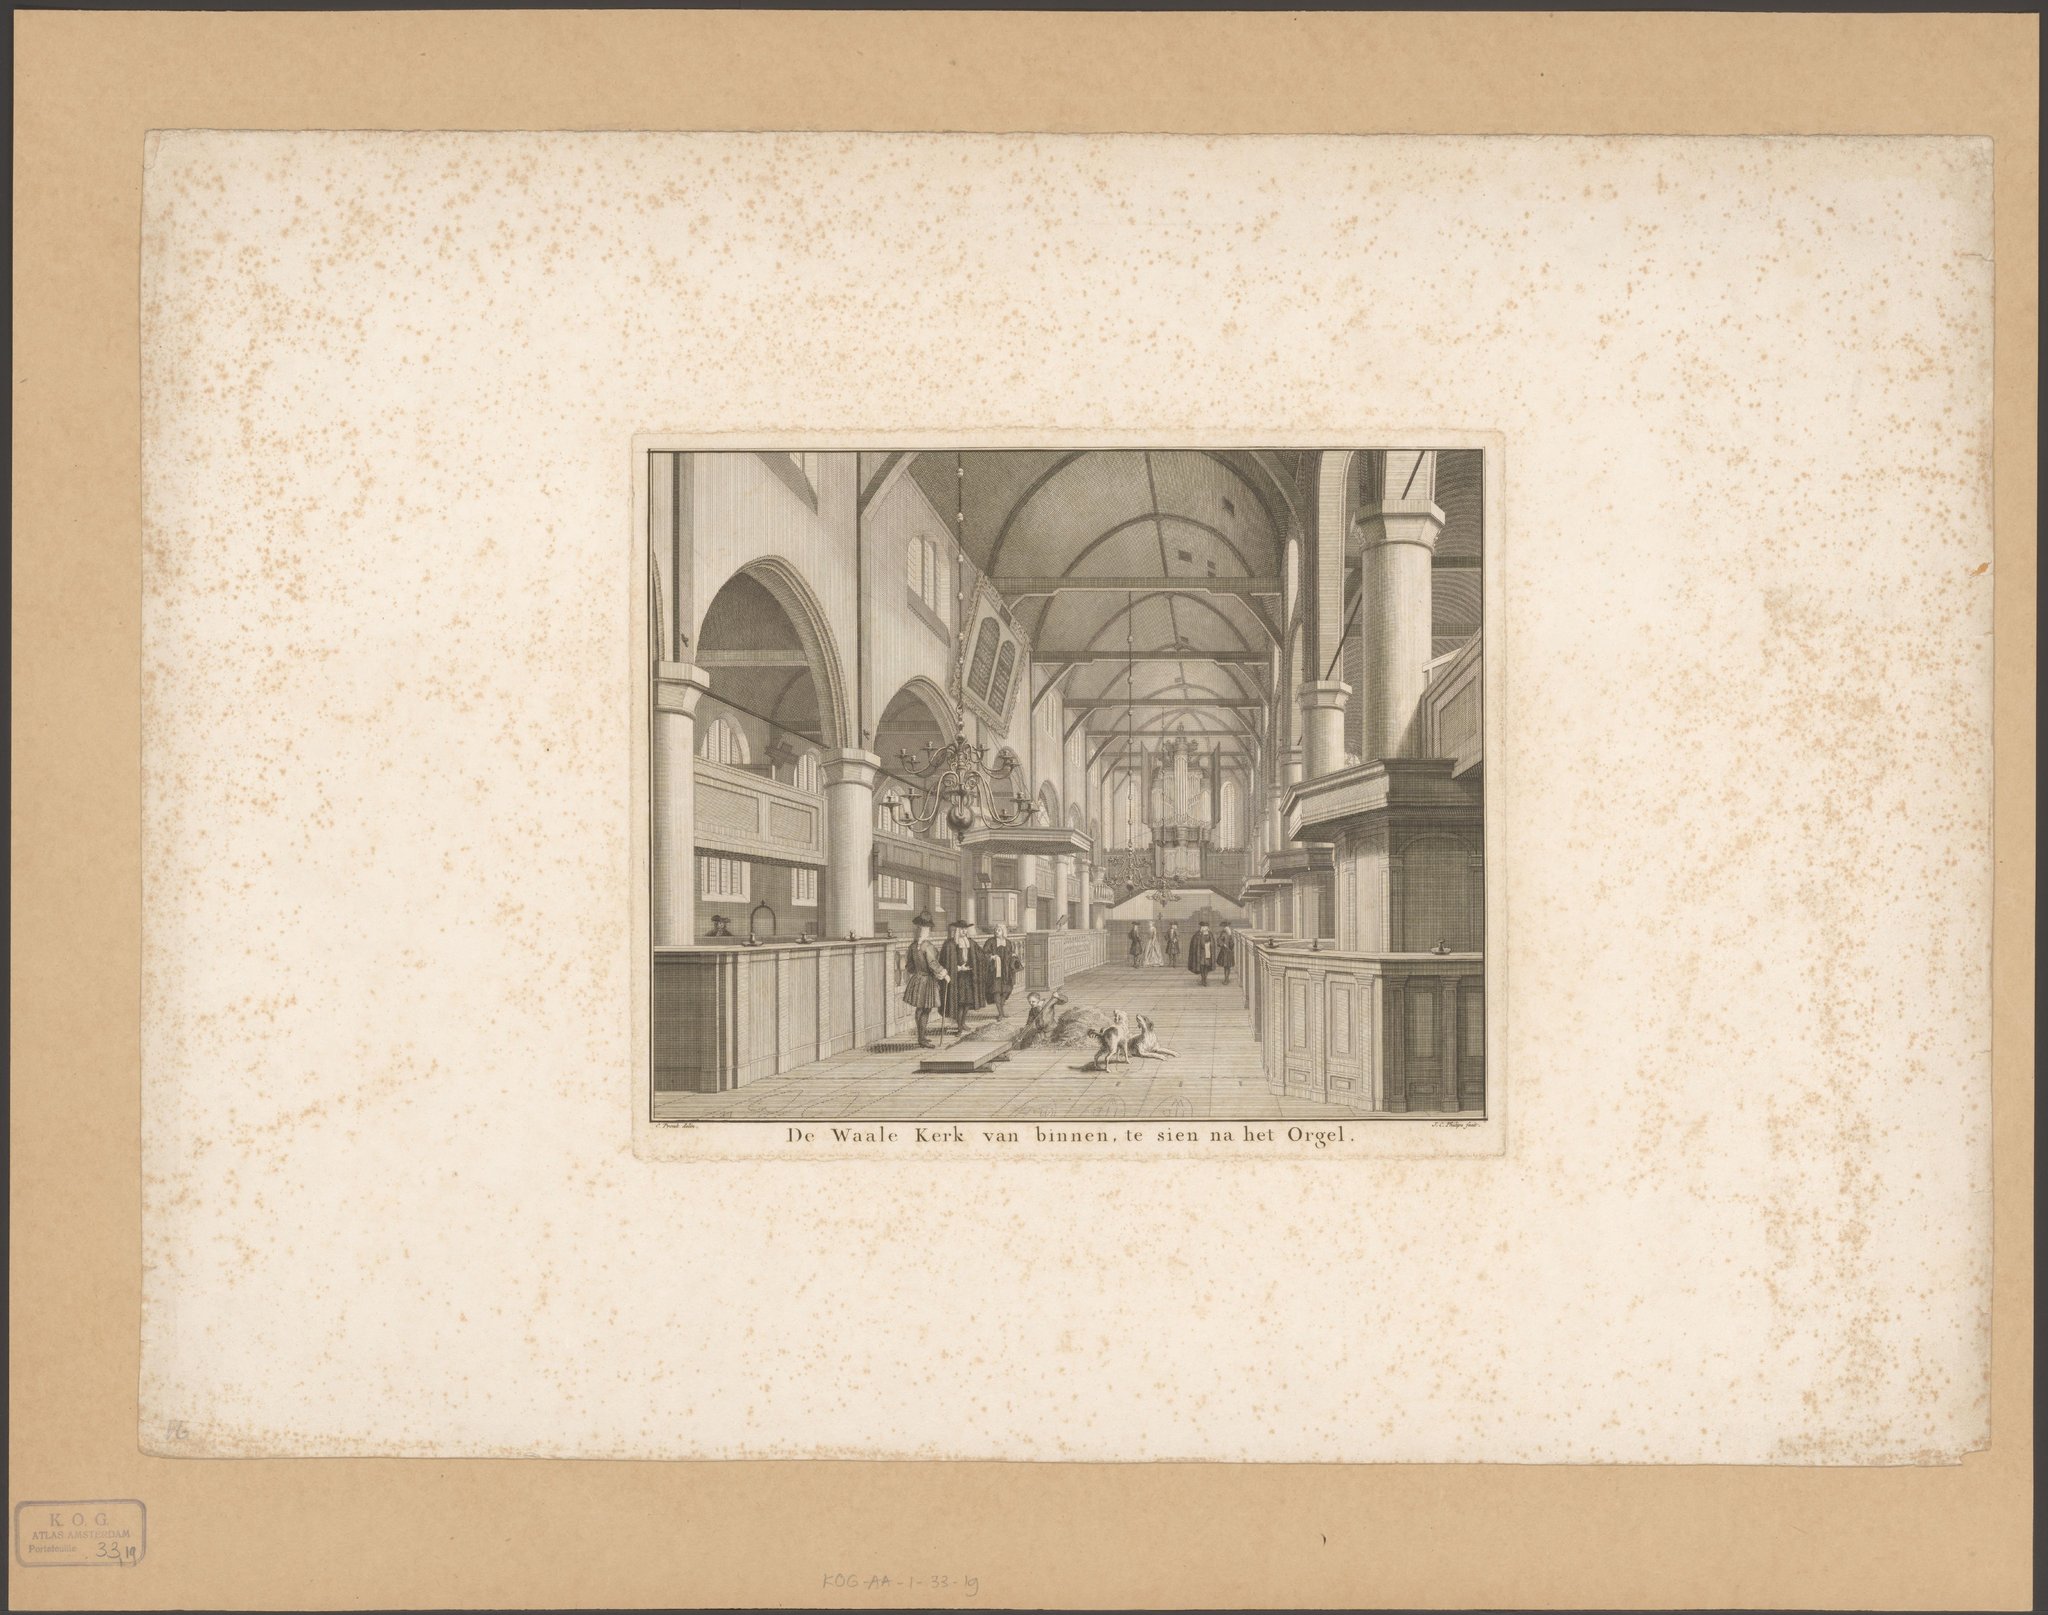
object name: print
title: De Waale Kerk van binnen, te sien na het Orgel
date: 1730-1759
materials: paper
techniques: engraving, etching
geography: amsterdam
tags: church organ, interior of church, grave digger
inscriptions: collector's mark: Lugt 1641b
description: Onderwerpsrubriek binnen de Atlas Amsterdam: Kerkwezen: Hervormde Gemeente: Waalse Gemeente.